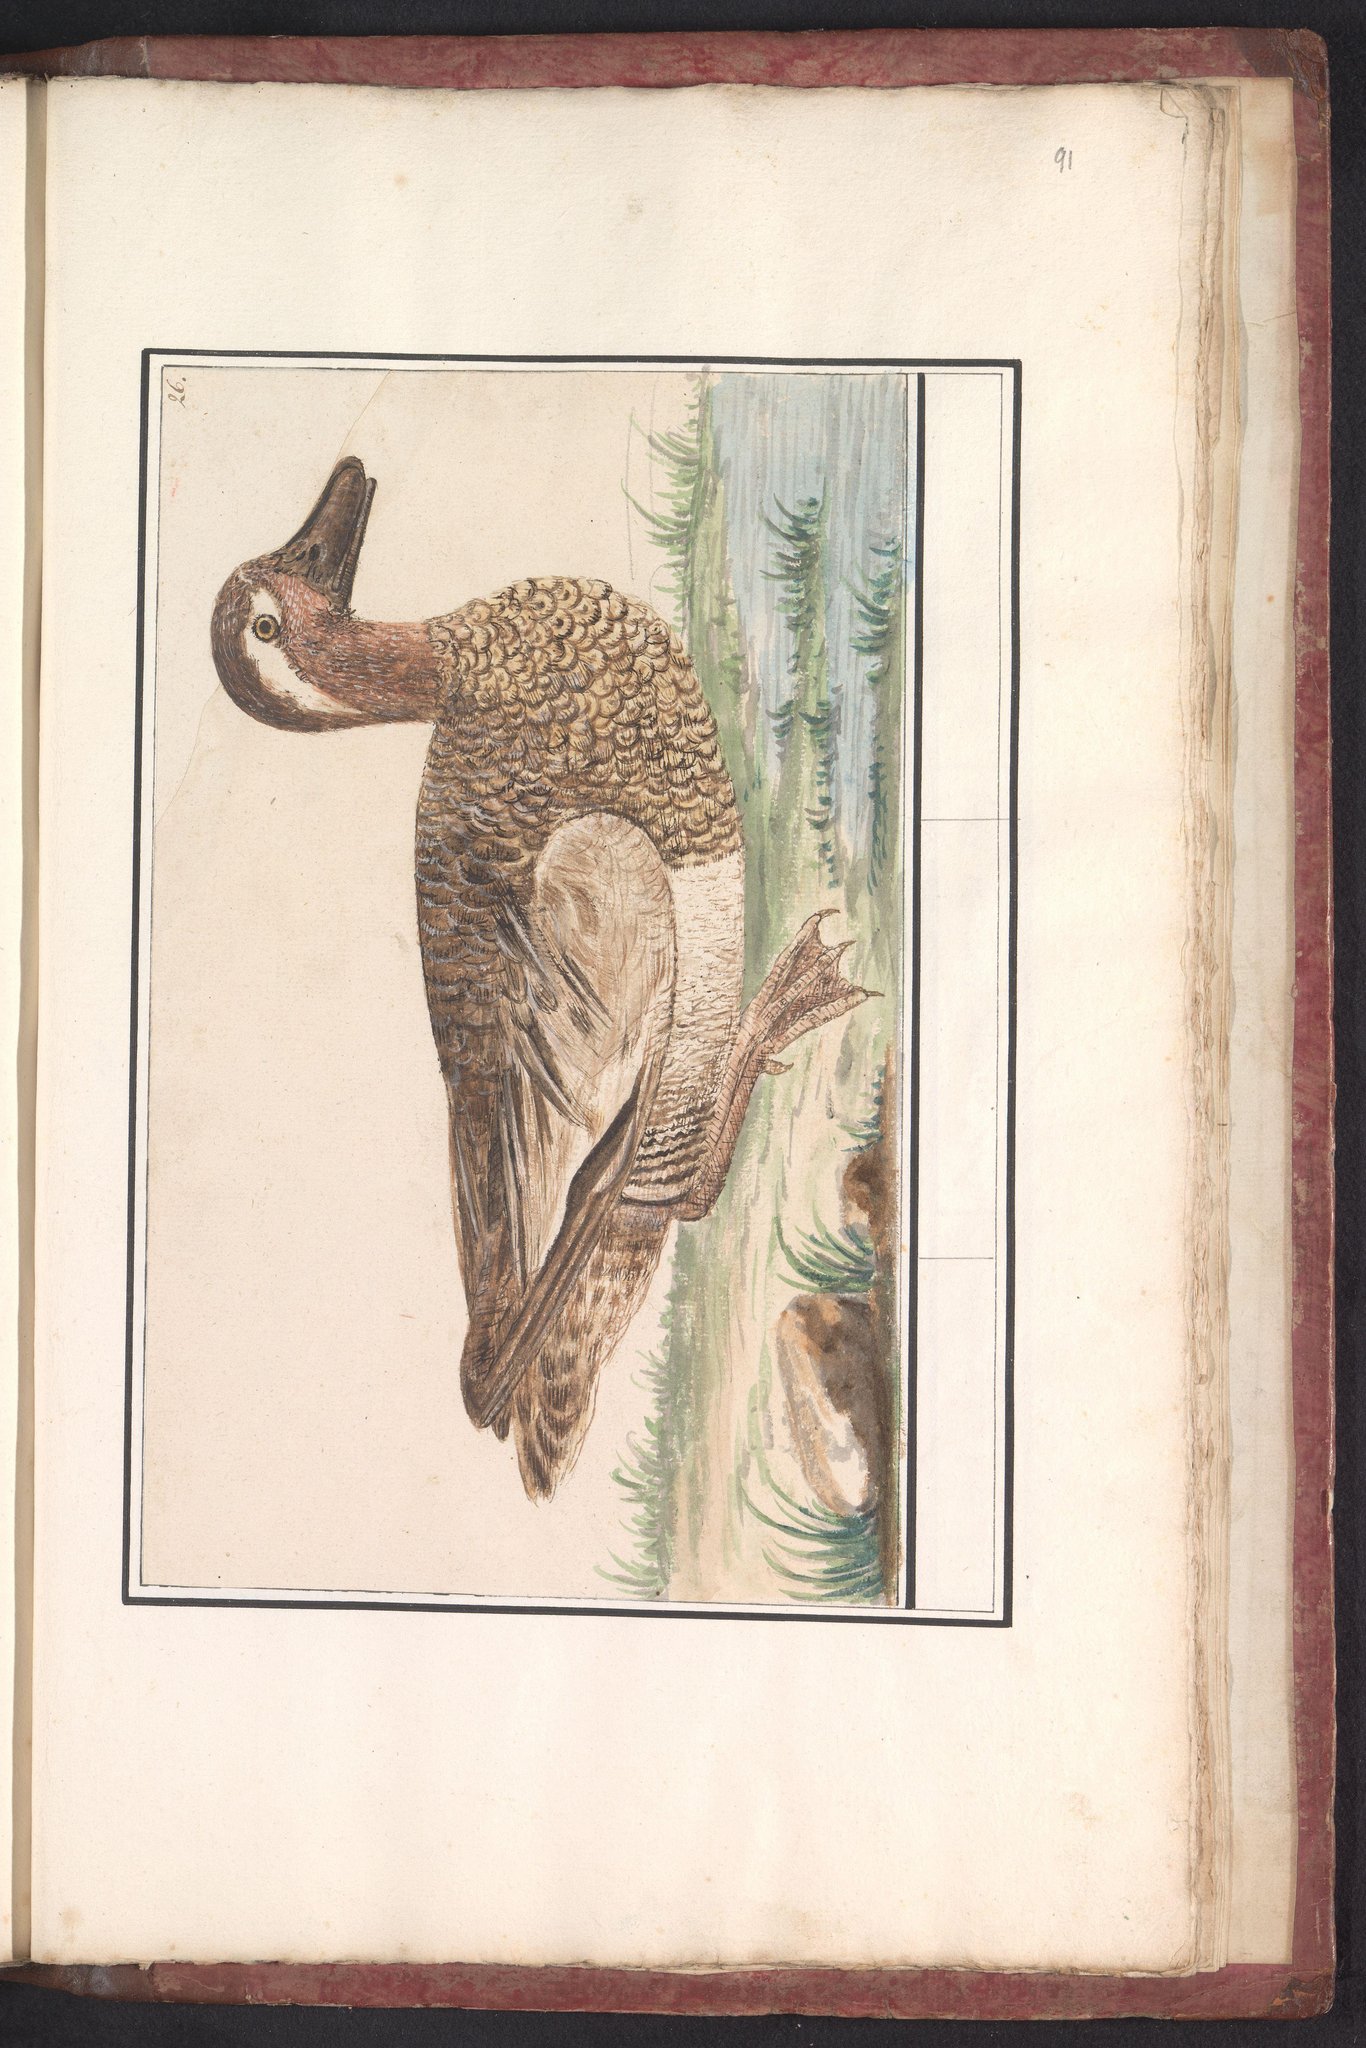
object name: drawing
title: Zomertaling (Anas querquedula)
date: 1596-1610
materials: chalk, paint, paper, pencil, watercolor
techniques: brush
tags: water-birds: garganey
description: Zomertaling. Genummerd rechtsboven: 26. Onderdeel van het derde album met tekeningen van vogels. Vijfde van twaalf albums met tekeningen van dieren, vogels en planten bekend rond 1600, gemaakt in opdracht van keizer Rudolf II. Met toelichting in Nederlands, Latijn en Frans.